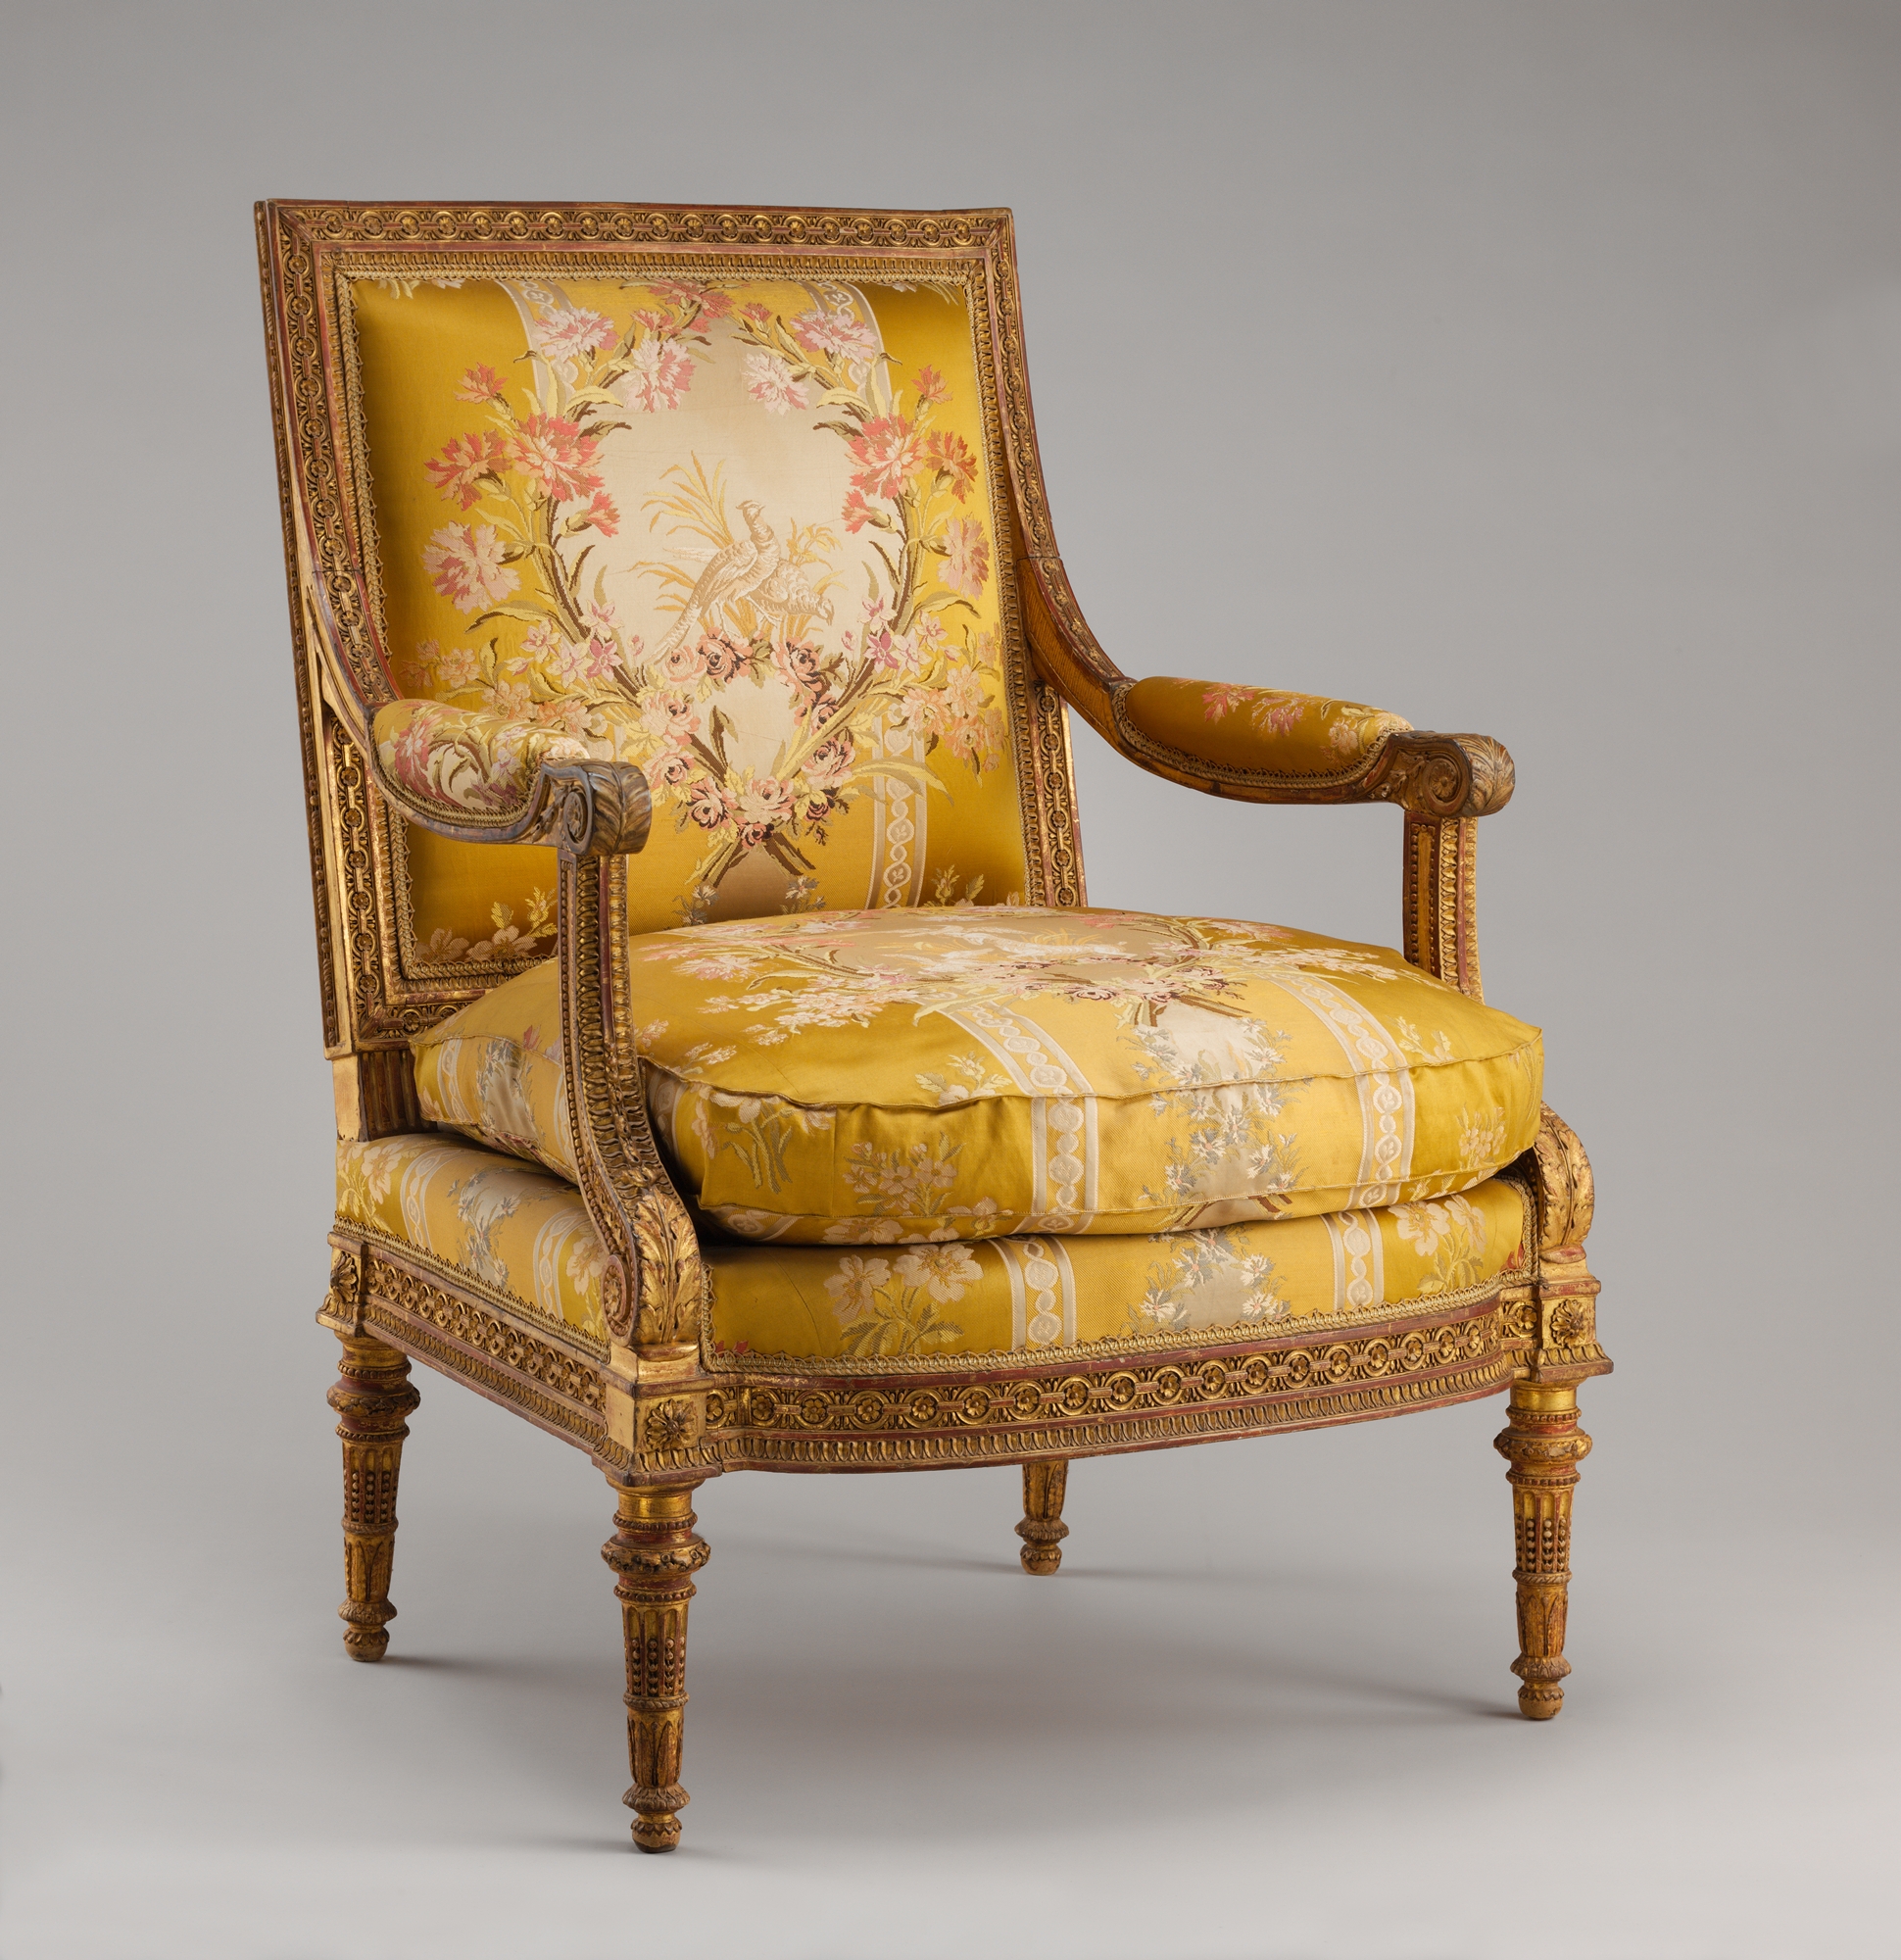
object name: armchair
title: Armchair (fauteuil) from Louis XVI's Salon des Jeux at Saint Cloud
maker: georges jacob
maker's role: maker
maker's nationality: french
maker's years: 1739-1814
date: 1788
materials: gold, silk, wood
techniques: brocade, carving, gilding